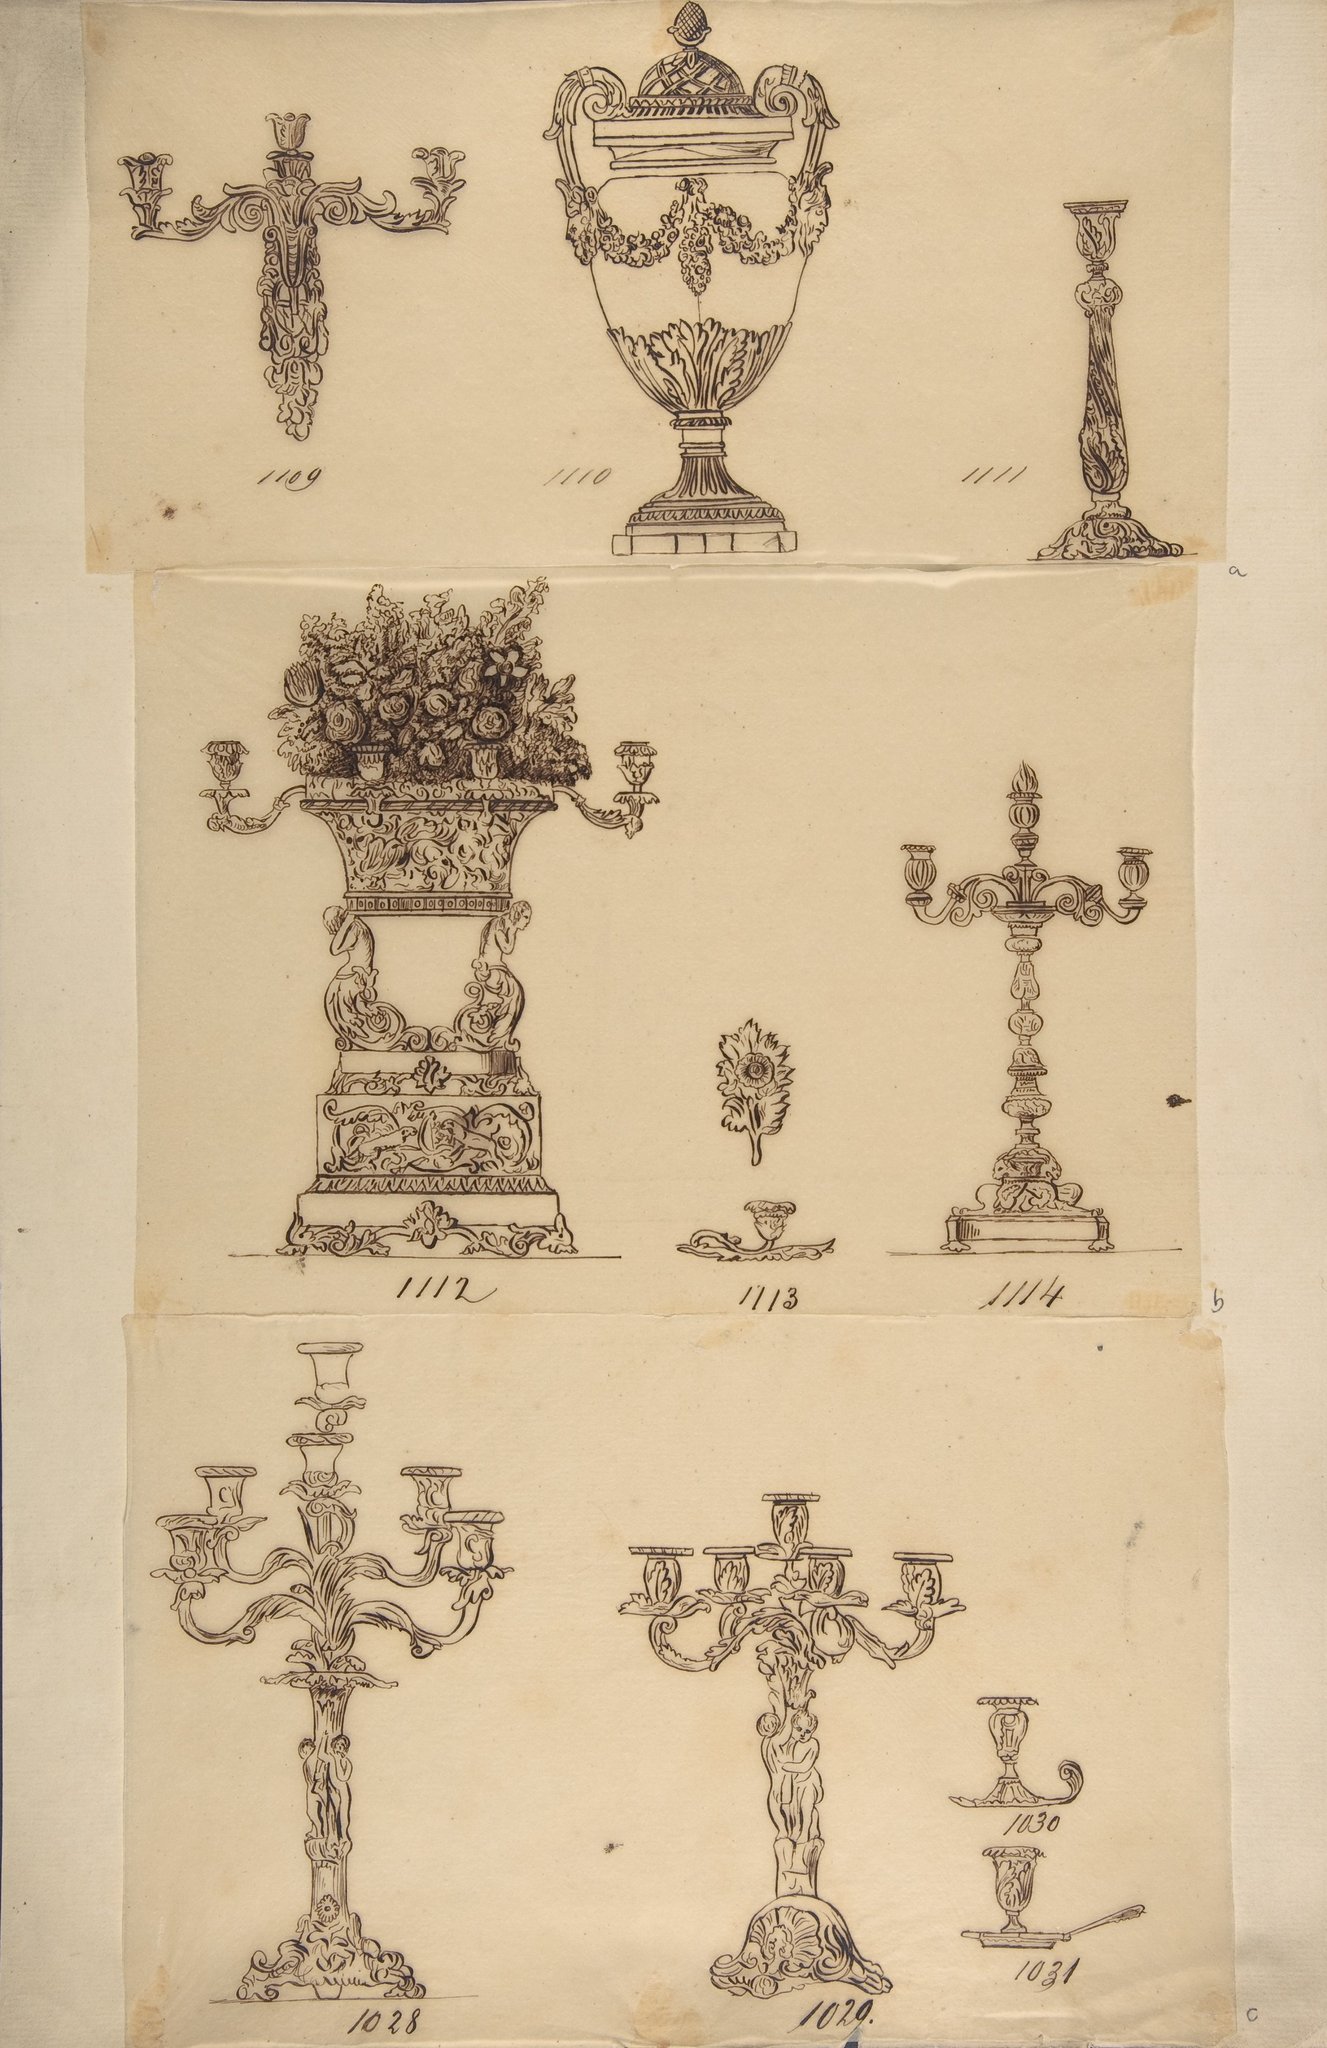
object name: drawing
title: Various Designs for Lighting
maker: anonymous, french, 19th century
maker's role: artist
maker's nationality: french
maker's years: 1800-1900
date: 1801-1900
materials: ink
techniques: pen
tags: lighting